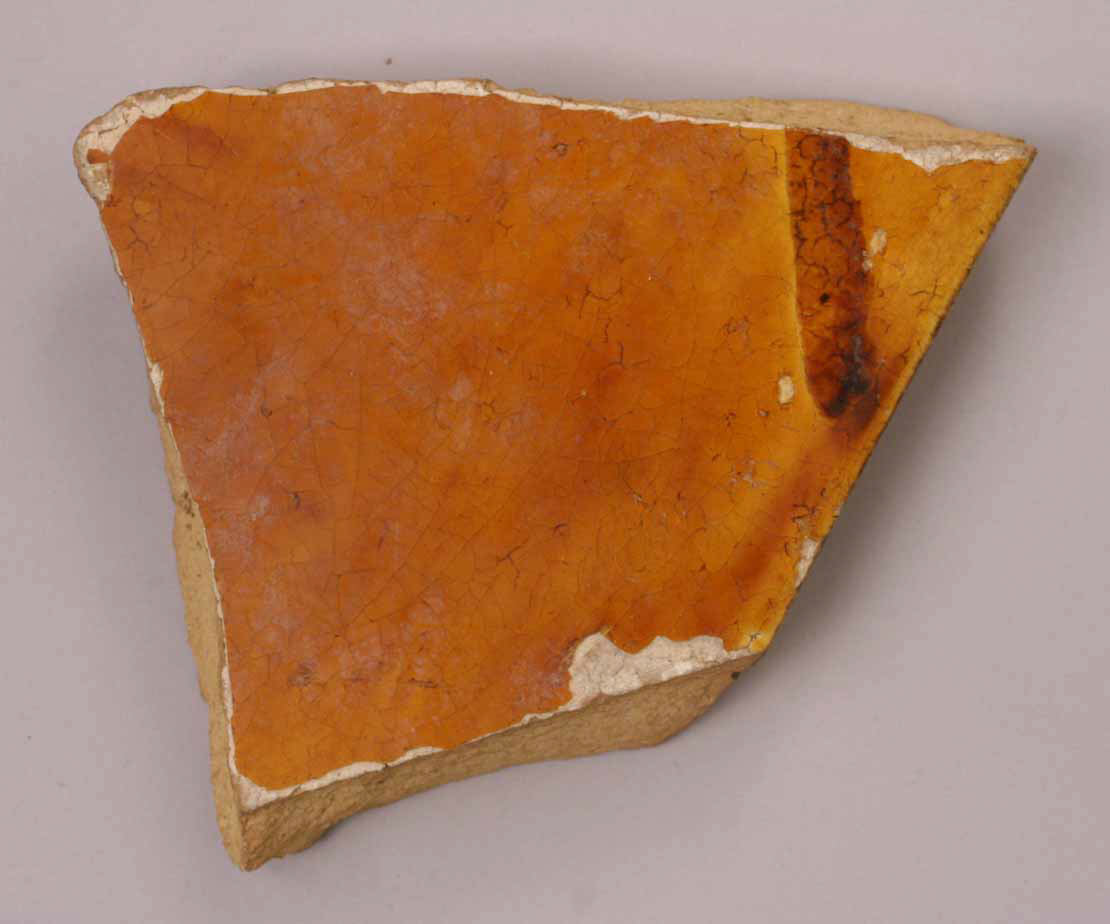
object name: fragment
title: Fragment of Sgraffito Ceramics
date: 801-900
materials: earthenware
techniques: glazing, incising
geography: iraq